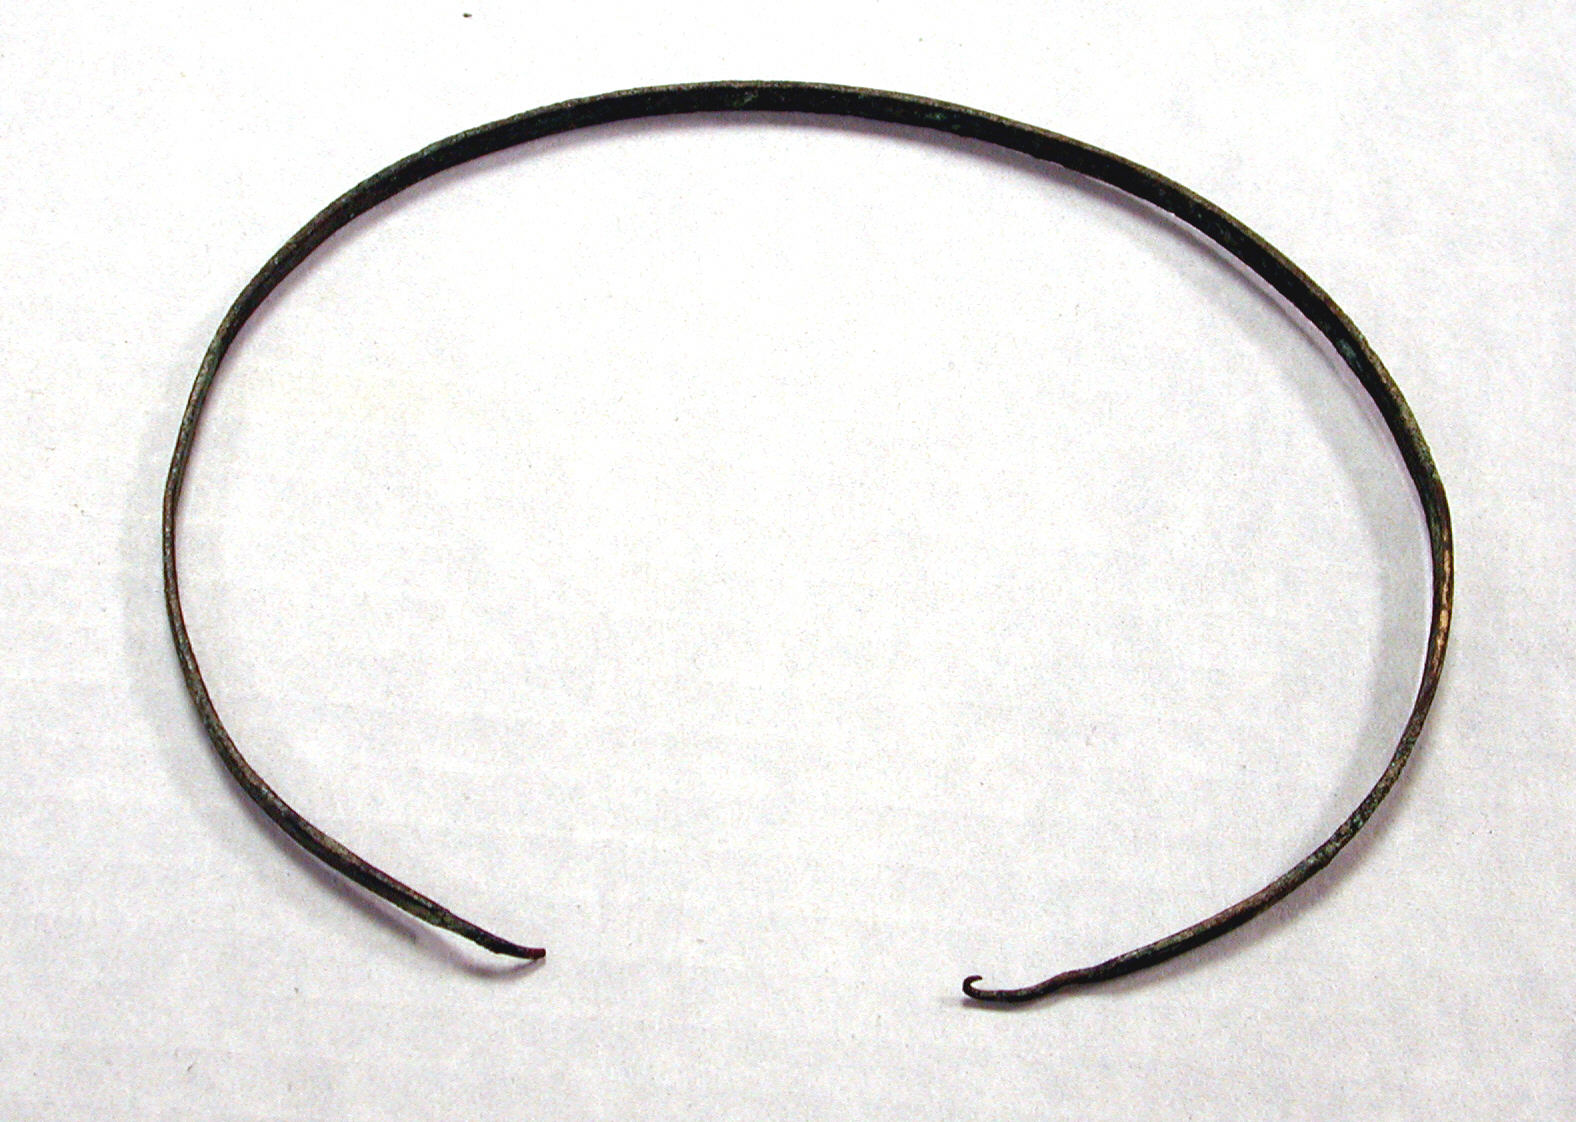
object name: ornament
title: Hammered Copper Band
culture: peruvian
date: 1450-1530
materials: copper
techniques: hammering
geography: peru